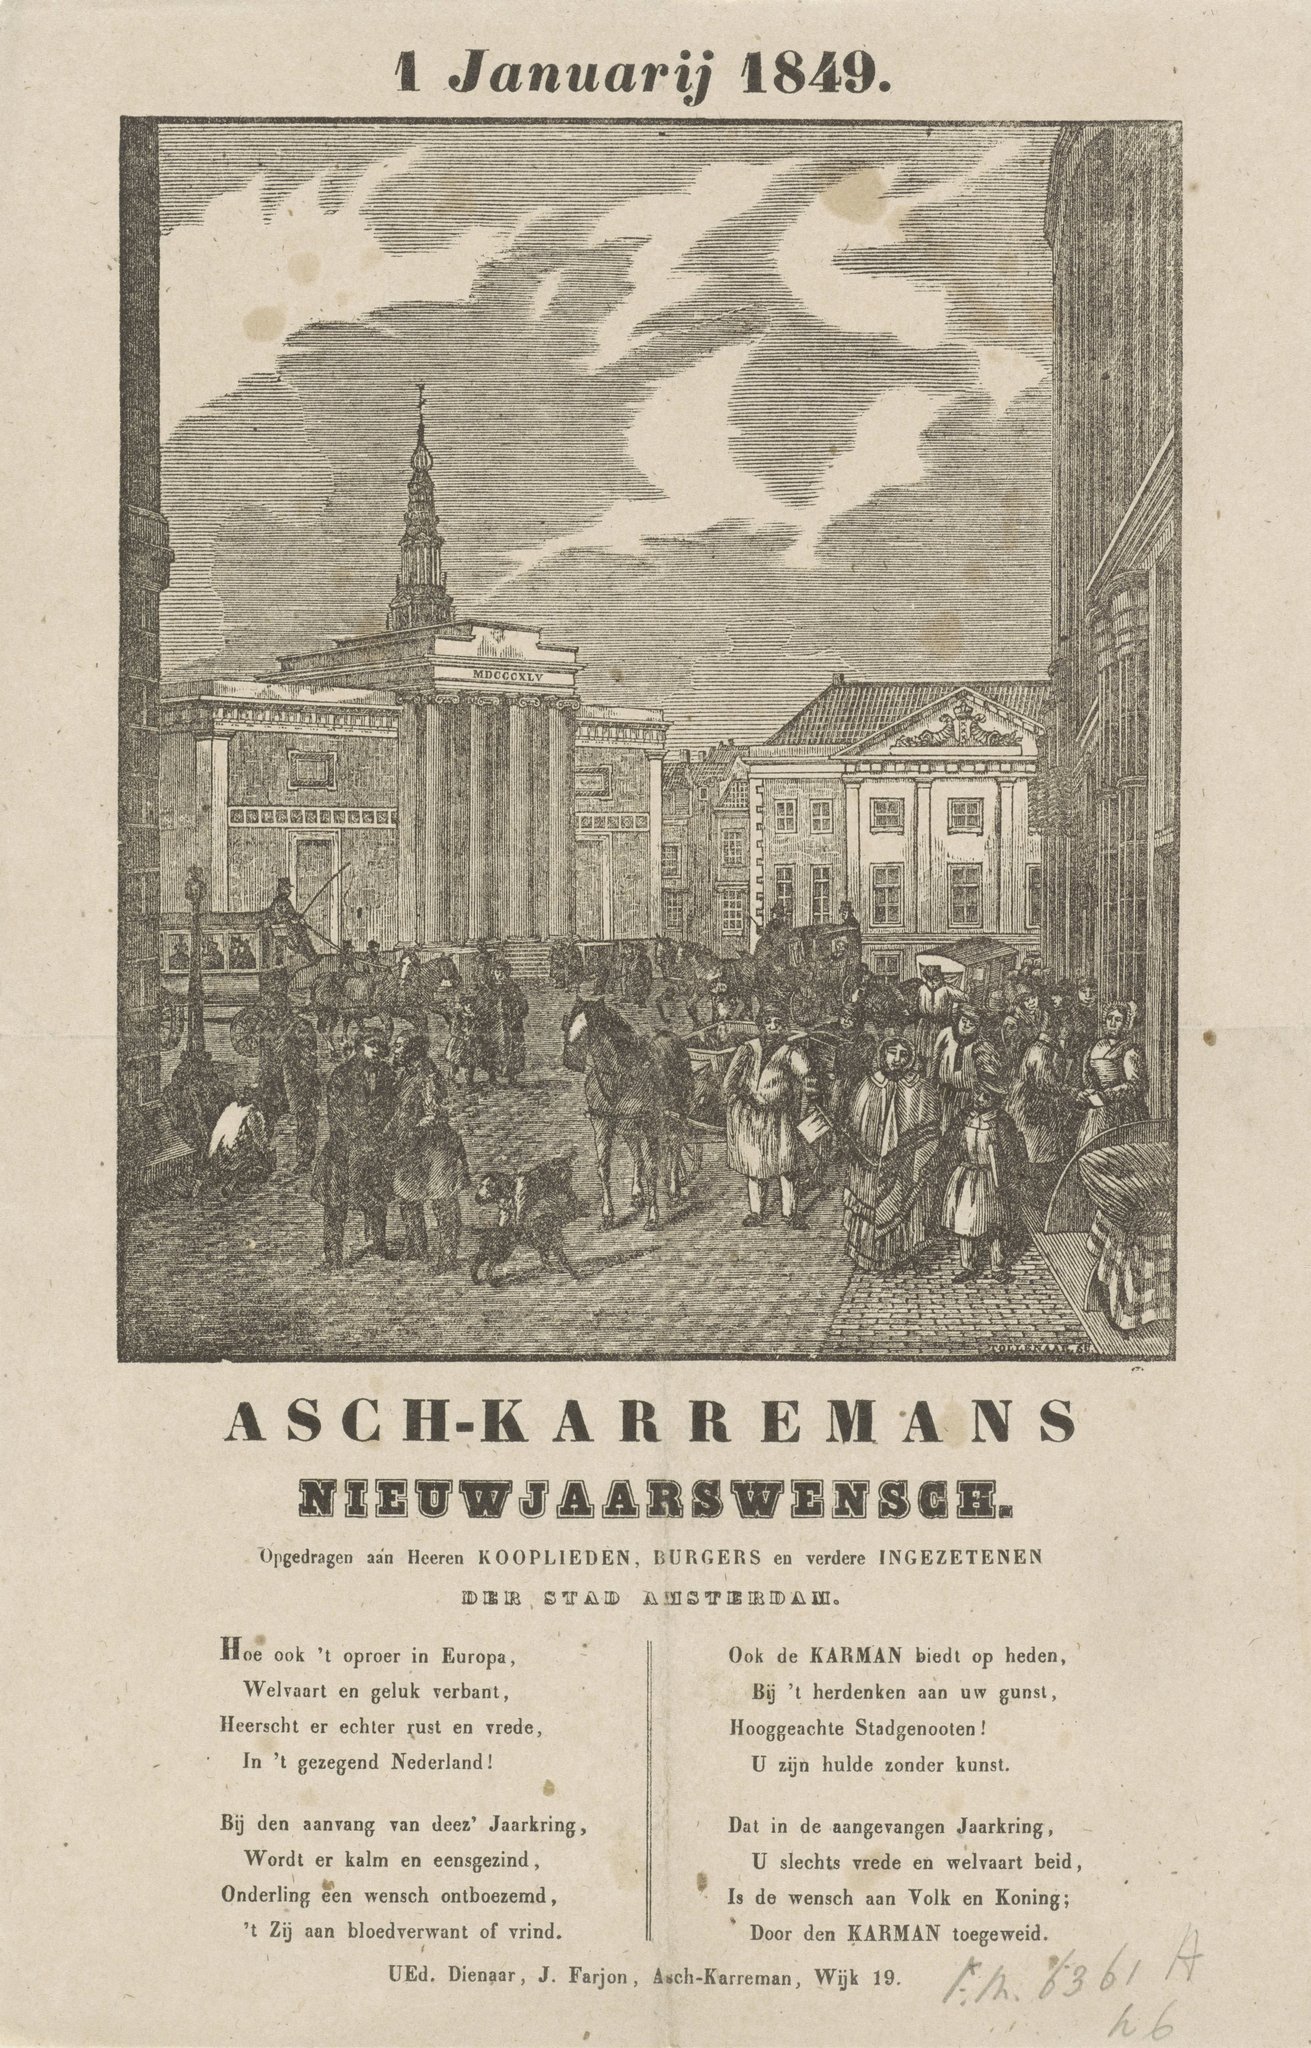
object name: print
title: 1 Januarij 1849 / Asch-Karremans Nieuwjaarswensch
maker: dirk wijbrand tollenaar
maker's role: print maker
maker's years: 1808-1858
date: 1848-1849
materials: paper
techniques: letterpress printing, engraving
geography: netherlands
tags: public road - ii - ideal city, garbage collection, amsterdam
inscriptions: collector's mark: Lugt 2228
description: Nieuwjaarswens namens de askarrenmannen (karrenman of vuilnisman) te Amsterdam voor het jaar 1849. Gezicht op de Dam te Amsterdam met de Beurs van Zocher en het Commandantshuis. Tussen het publiek de vuilnismannen met hun kar. Onderaan een gedicht in twee kolommen. Namens J. Farjon, de askarreman van wijk no. 19.